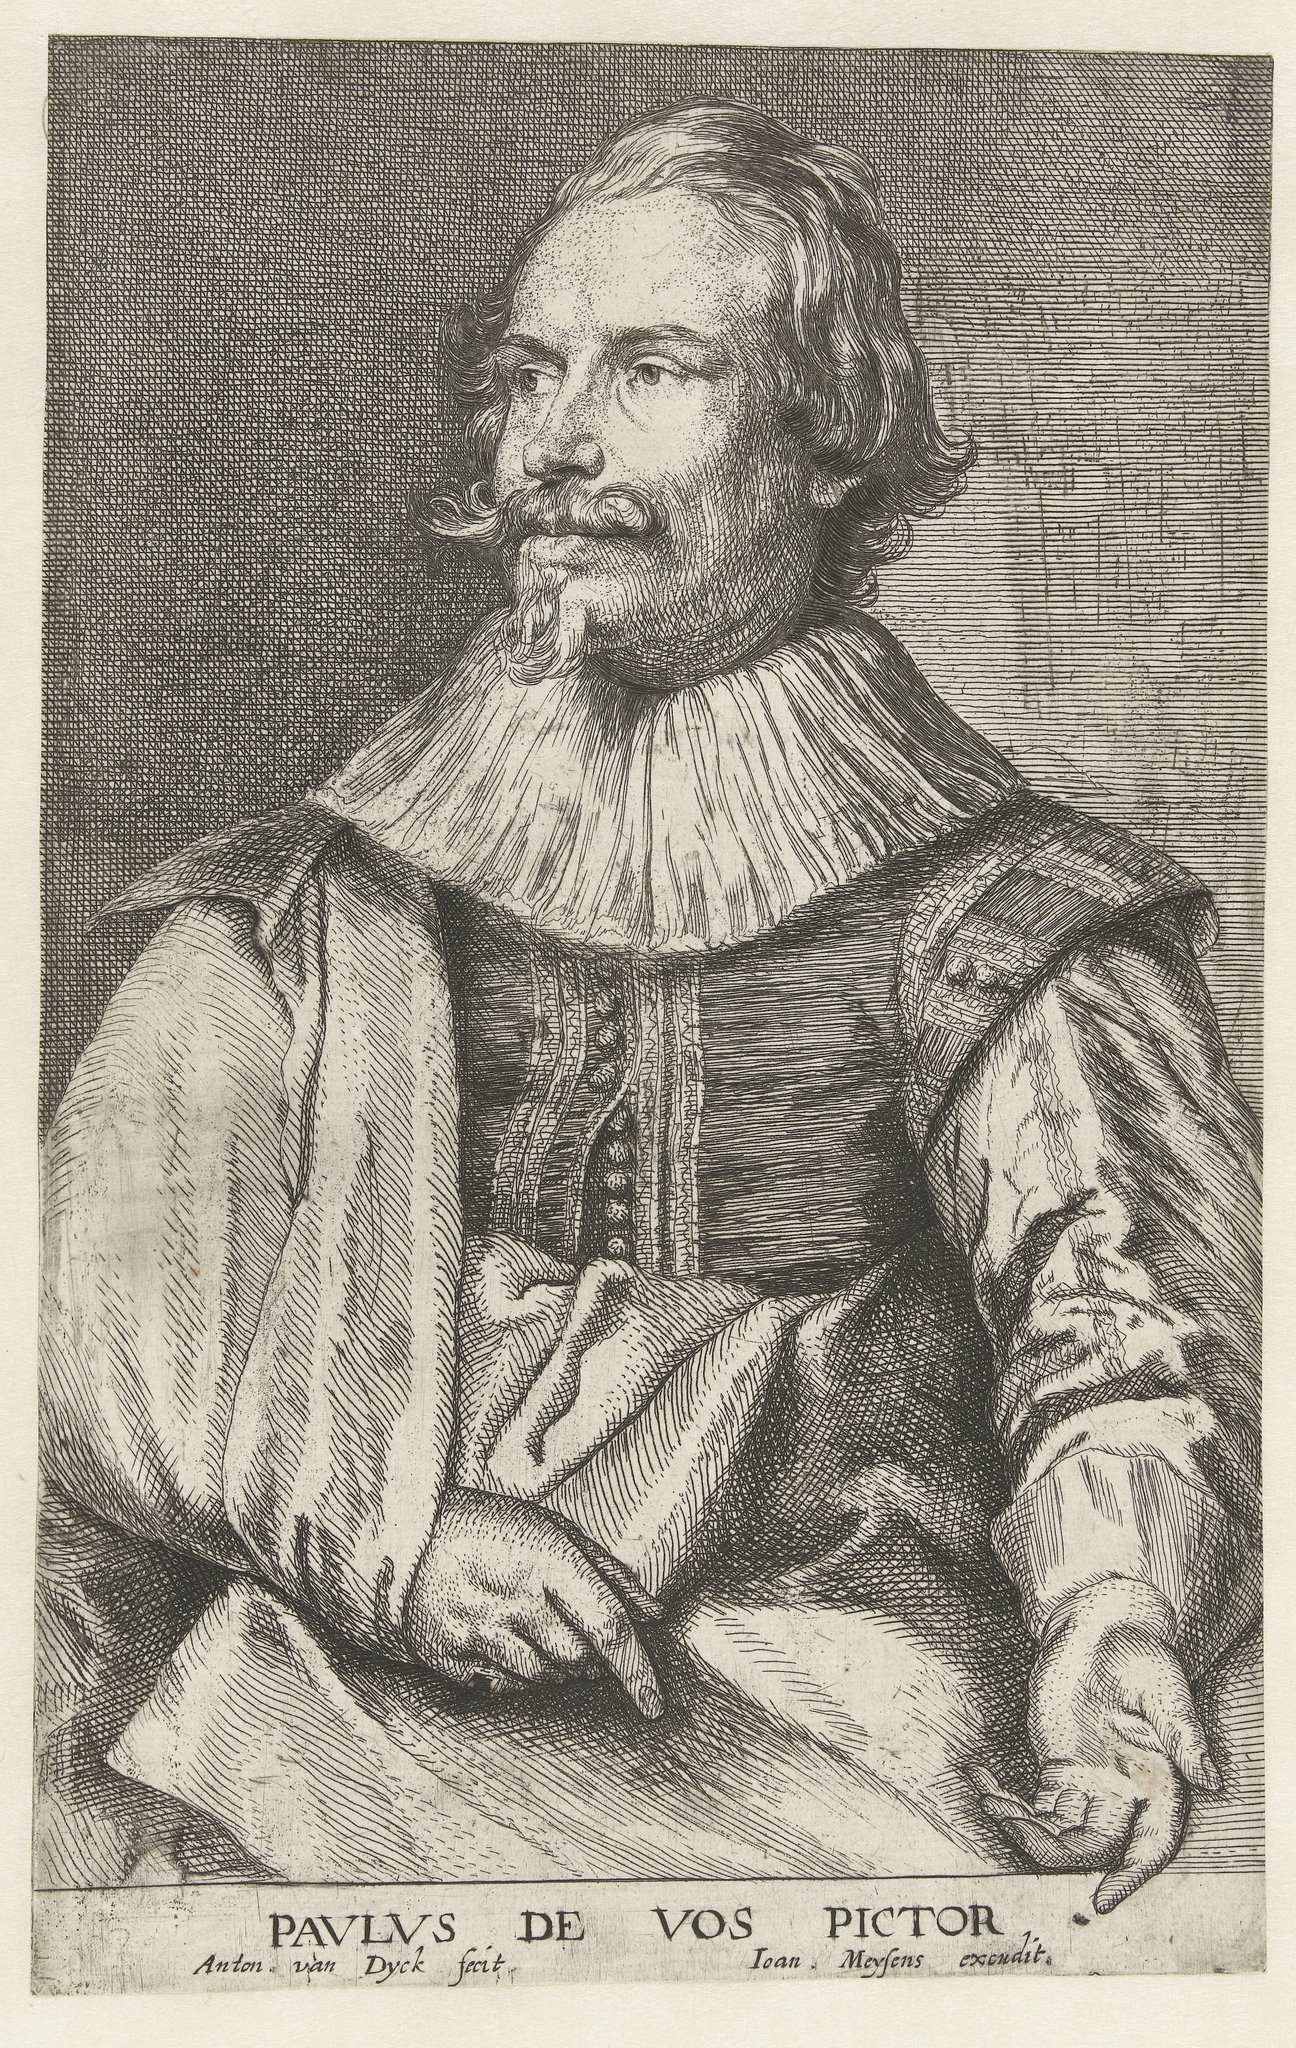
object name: print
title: Iconographie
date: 1630-1641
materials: paper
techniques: etching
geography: low countries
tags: antwerp, paul de vos, portrait, self-portrait of painter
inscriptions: collector's mark: Lugt 240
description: Portret van Paul de Vos met onderschrift PAVLVS DE VOS PICTOR